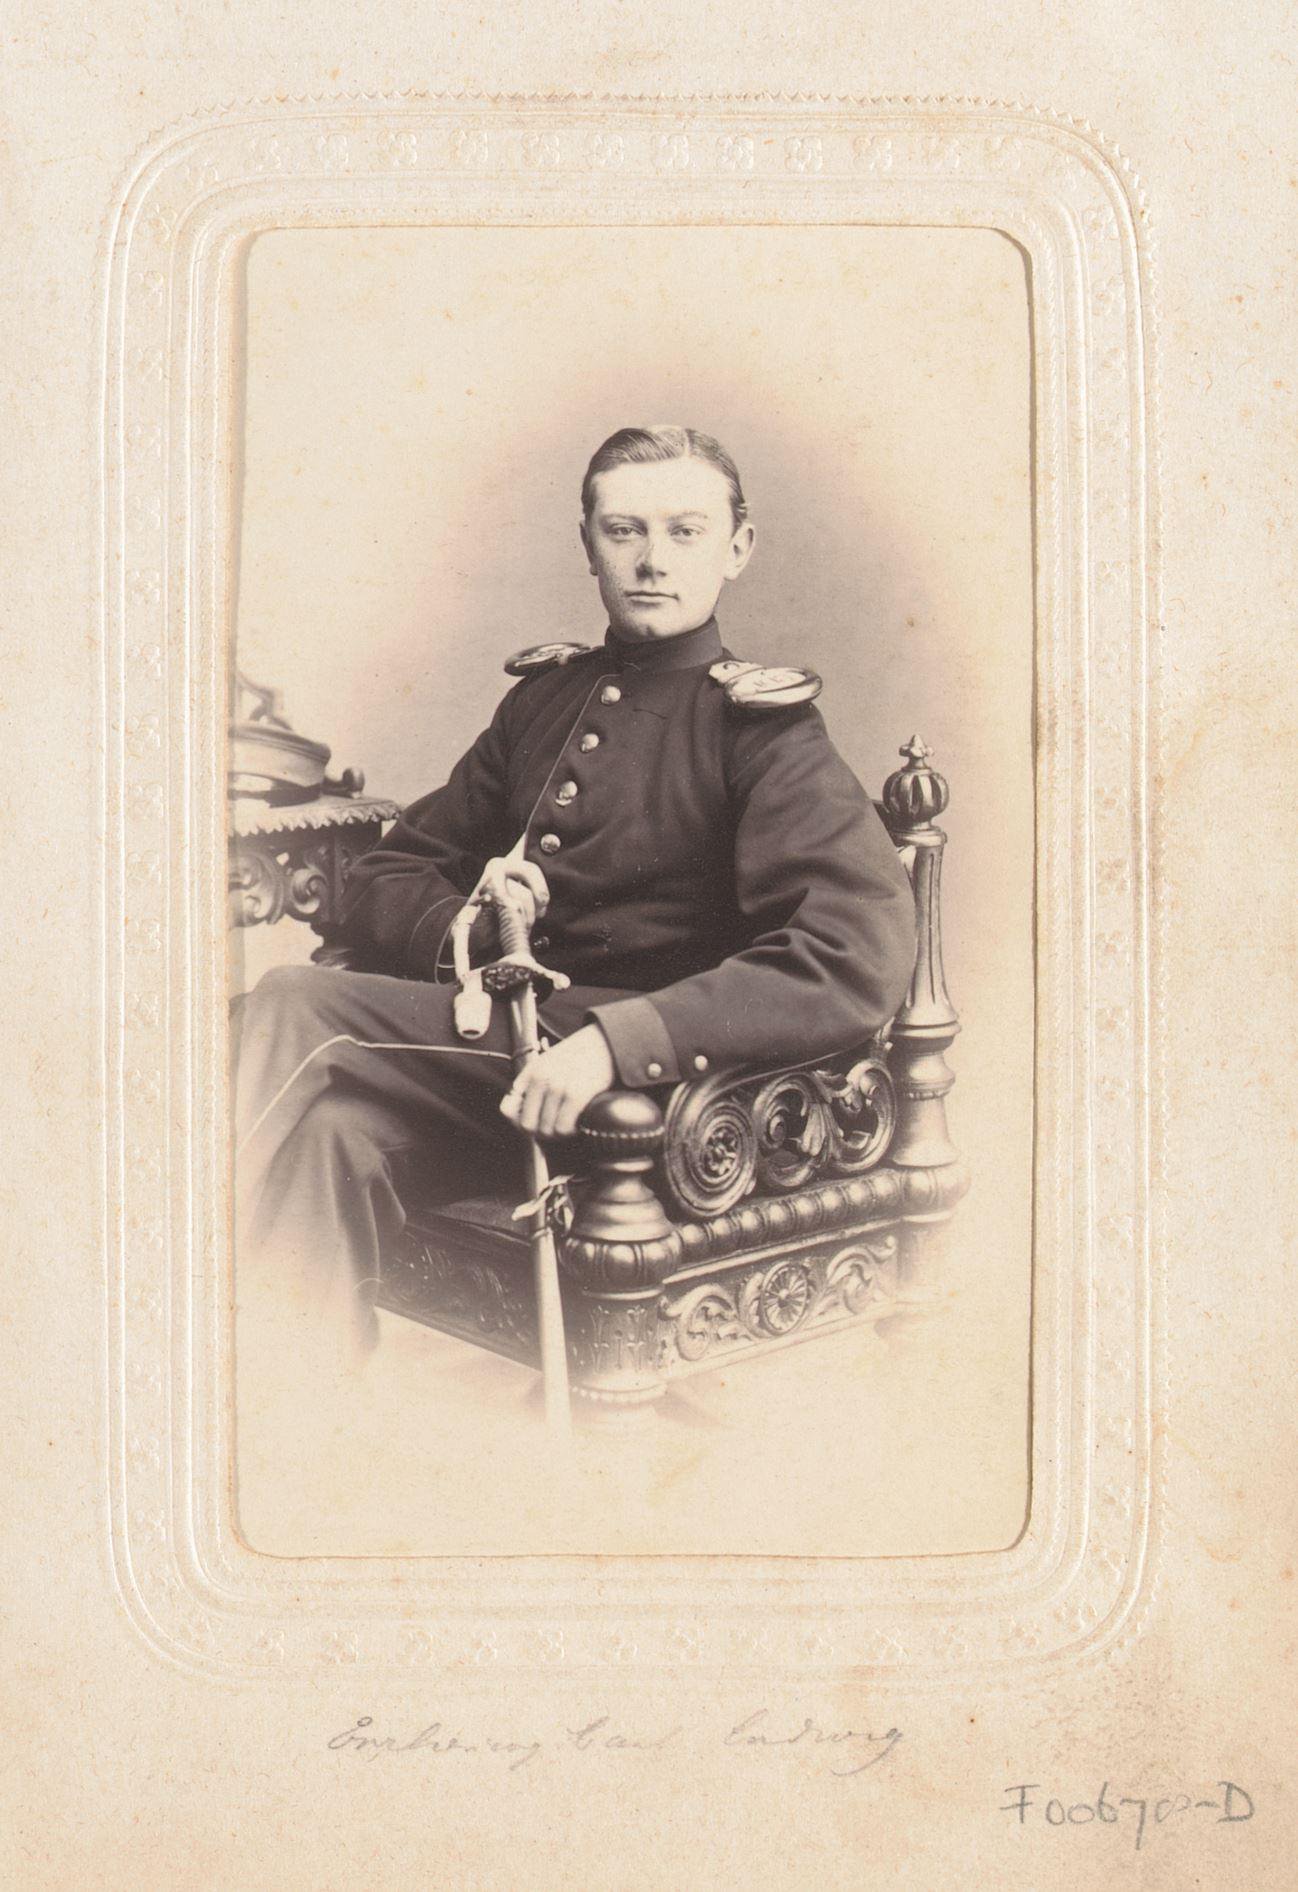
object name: photograph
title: Portret van Karel Lodewijk, aartshertog van Oostenrijk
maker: emil tietze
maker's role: fotograaf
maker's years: 1840-1931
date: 1860-1880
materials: cardboard, photographic support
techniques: albumen print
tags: vienna, historical persons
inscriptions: inscription: ‘Emil Tietze/ Photographisches Atelier/ Bad Elster/ Parkstrasse Carslruh.’, annotation: ‘Erzhertzog Carl Ludwig’